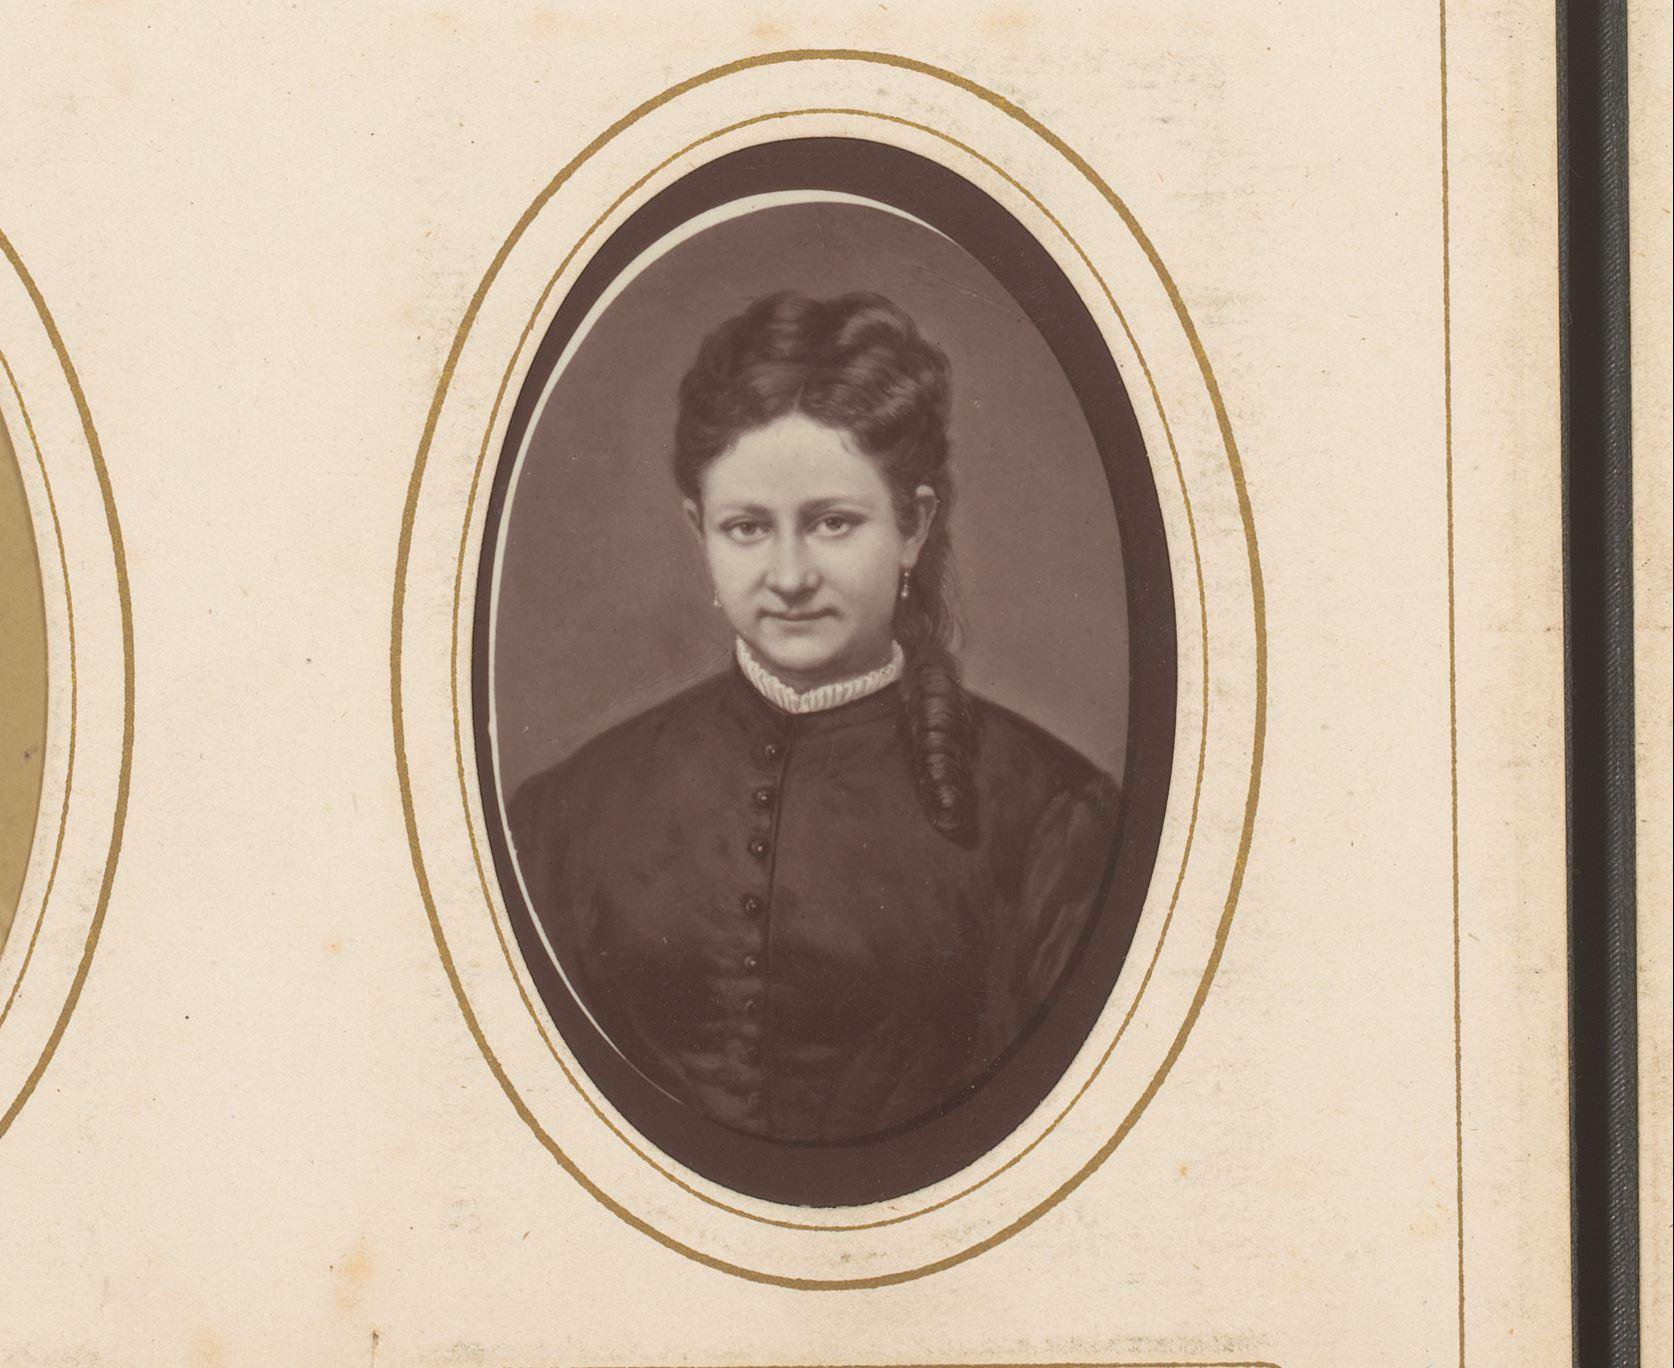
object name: photograph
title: Portret van een vrouw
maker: prosper bevierre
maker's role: fotograaf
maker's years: 1822-1893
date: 1865-1890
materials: cardboard, paper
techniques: carbon print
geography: charleroi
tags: historical persons - bb - woman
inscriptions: inscription: ‘Prosper Bevierre./ CHARLEROI./ Charbon. - Inaltérable.’